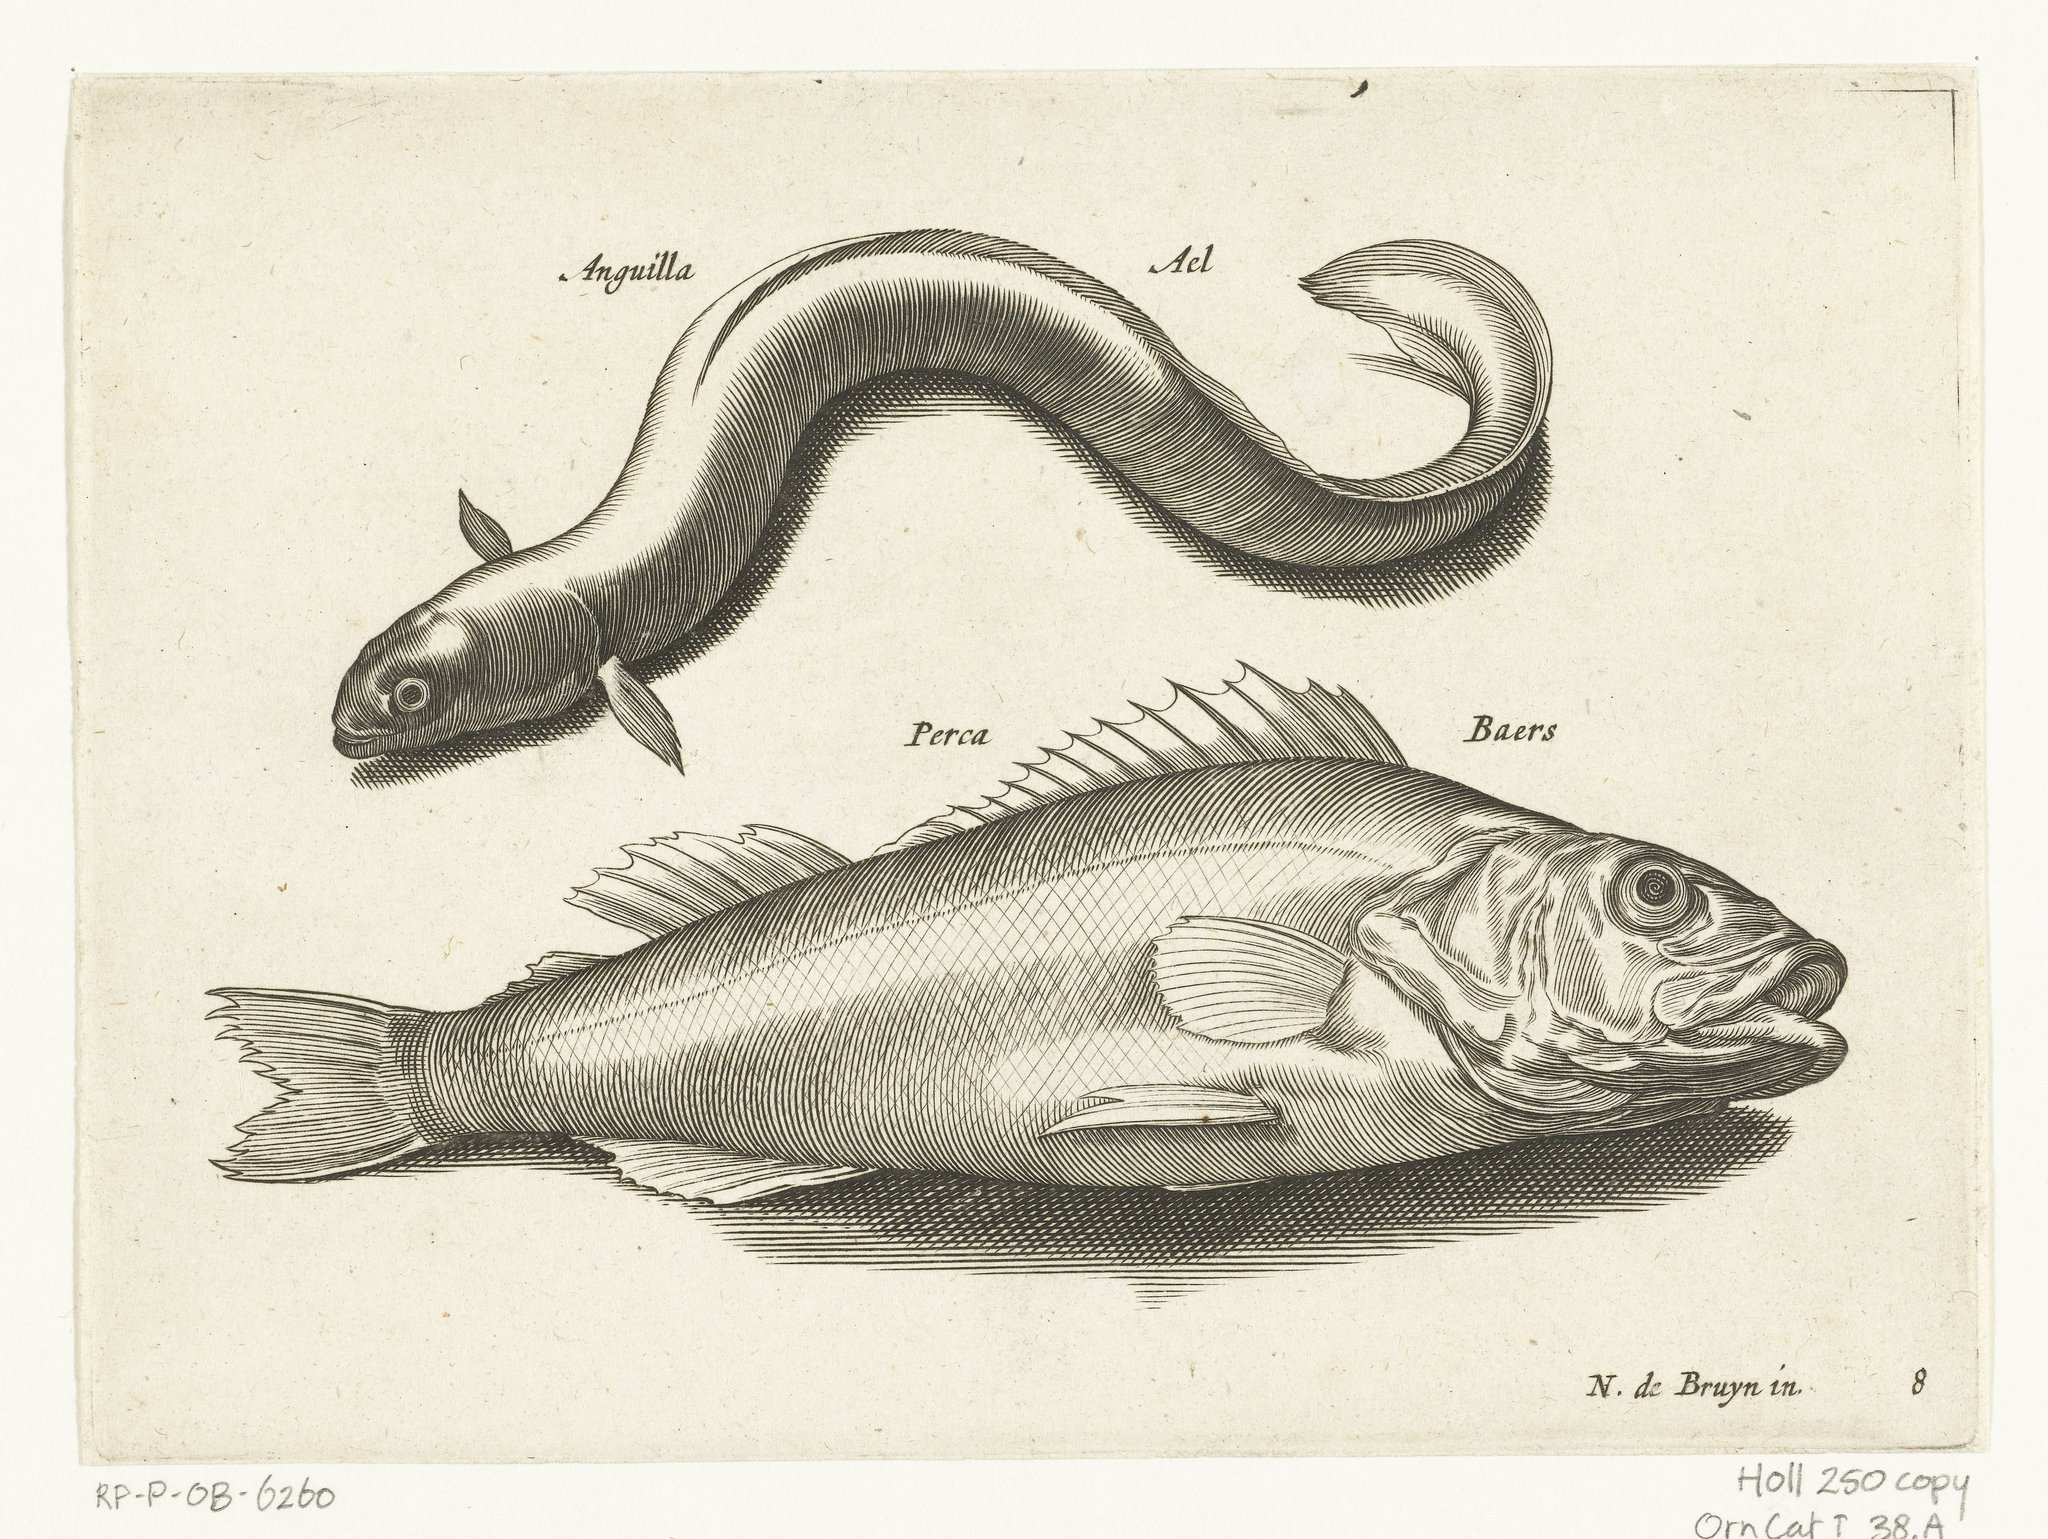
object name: print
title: Aal en baars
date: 1581-1652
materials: paper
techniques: engraving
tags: fishes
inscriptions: collector's mark: Lugt 2228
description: Kopie naar prent van Nicolaas de Bruyn uit serie Libelivs varia Genera piscium complectens van dertien prenten met zoetwatervissen, zeevissen, kikkers, schaaldieren en zeewezens (inclusief titelprent).